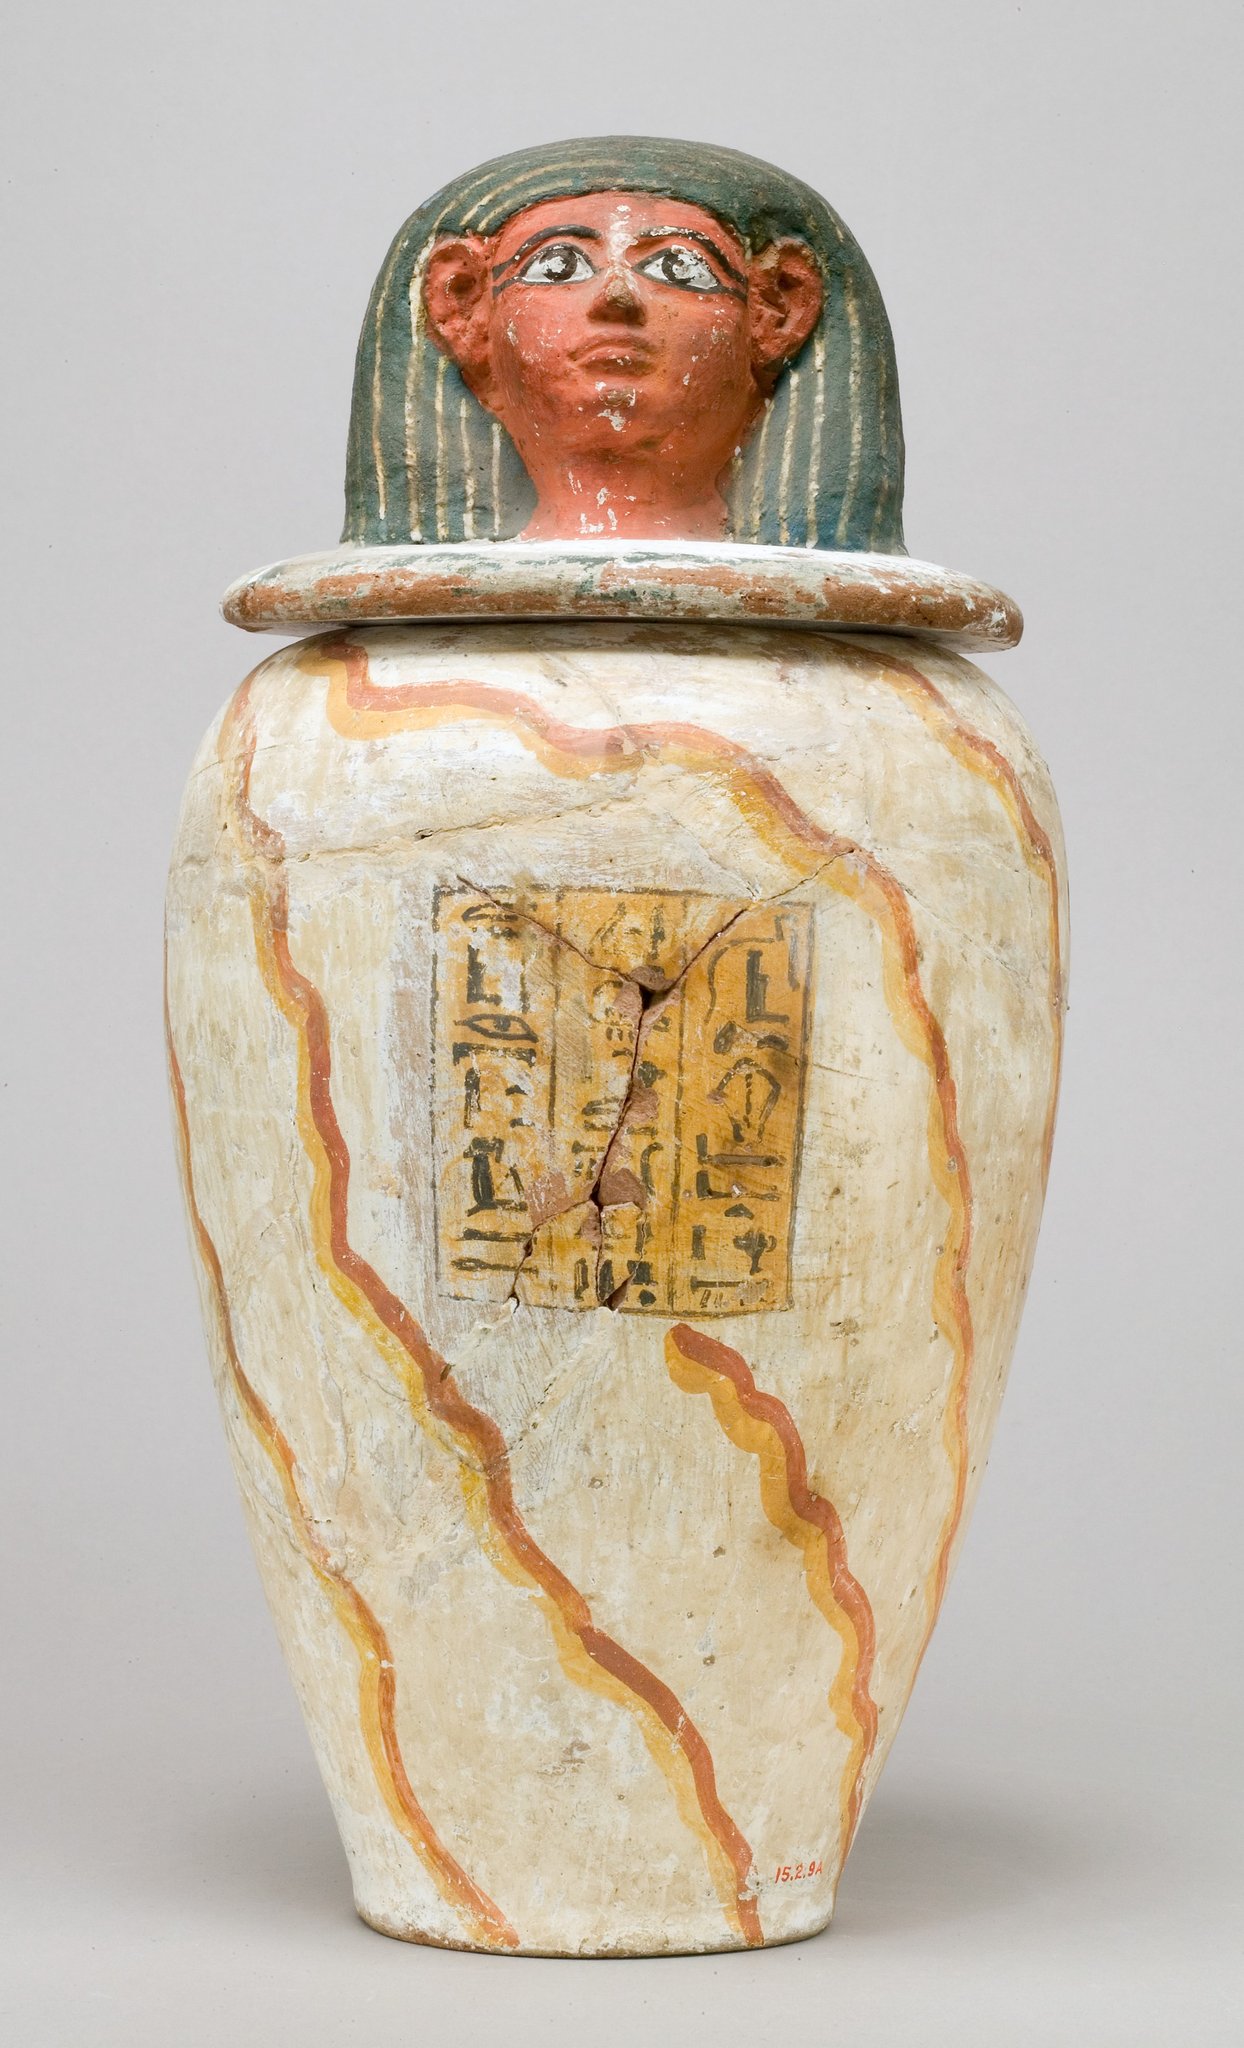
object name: canopic jar, teti, human head, faux, imseti, isi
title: Canopic Jar of Teti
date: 1479-1390 BCE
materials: paint, pottery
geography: egypt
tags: hieroglyphs